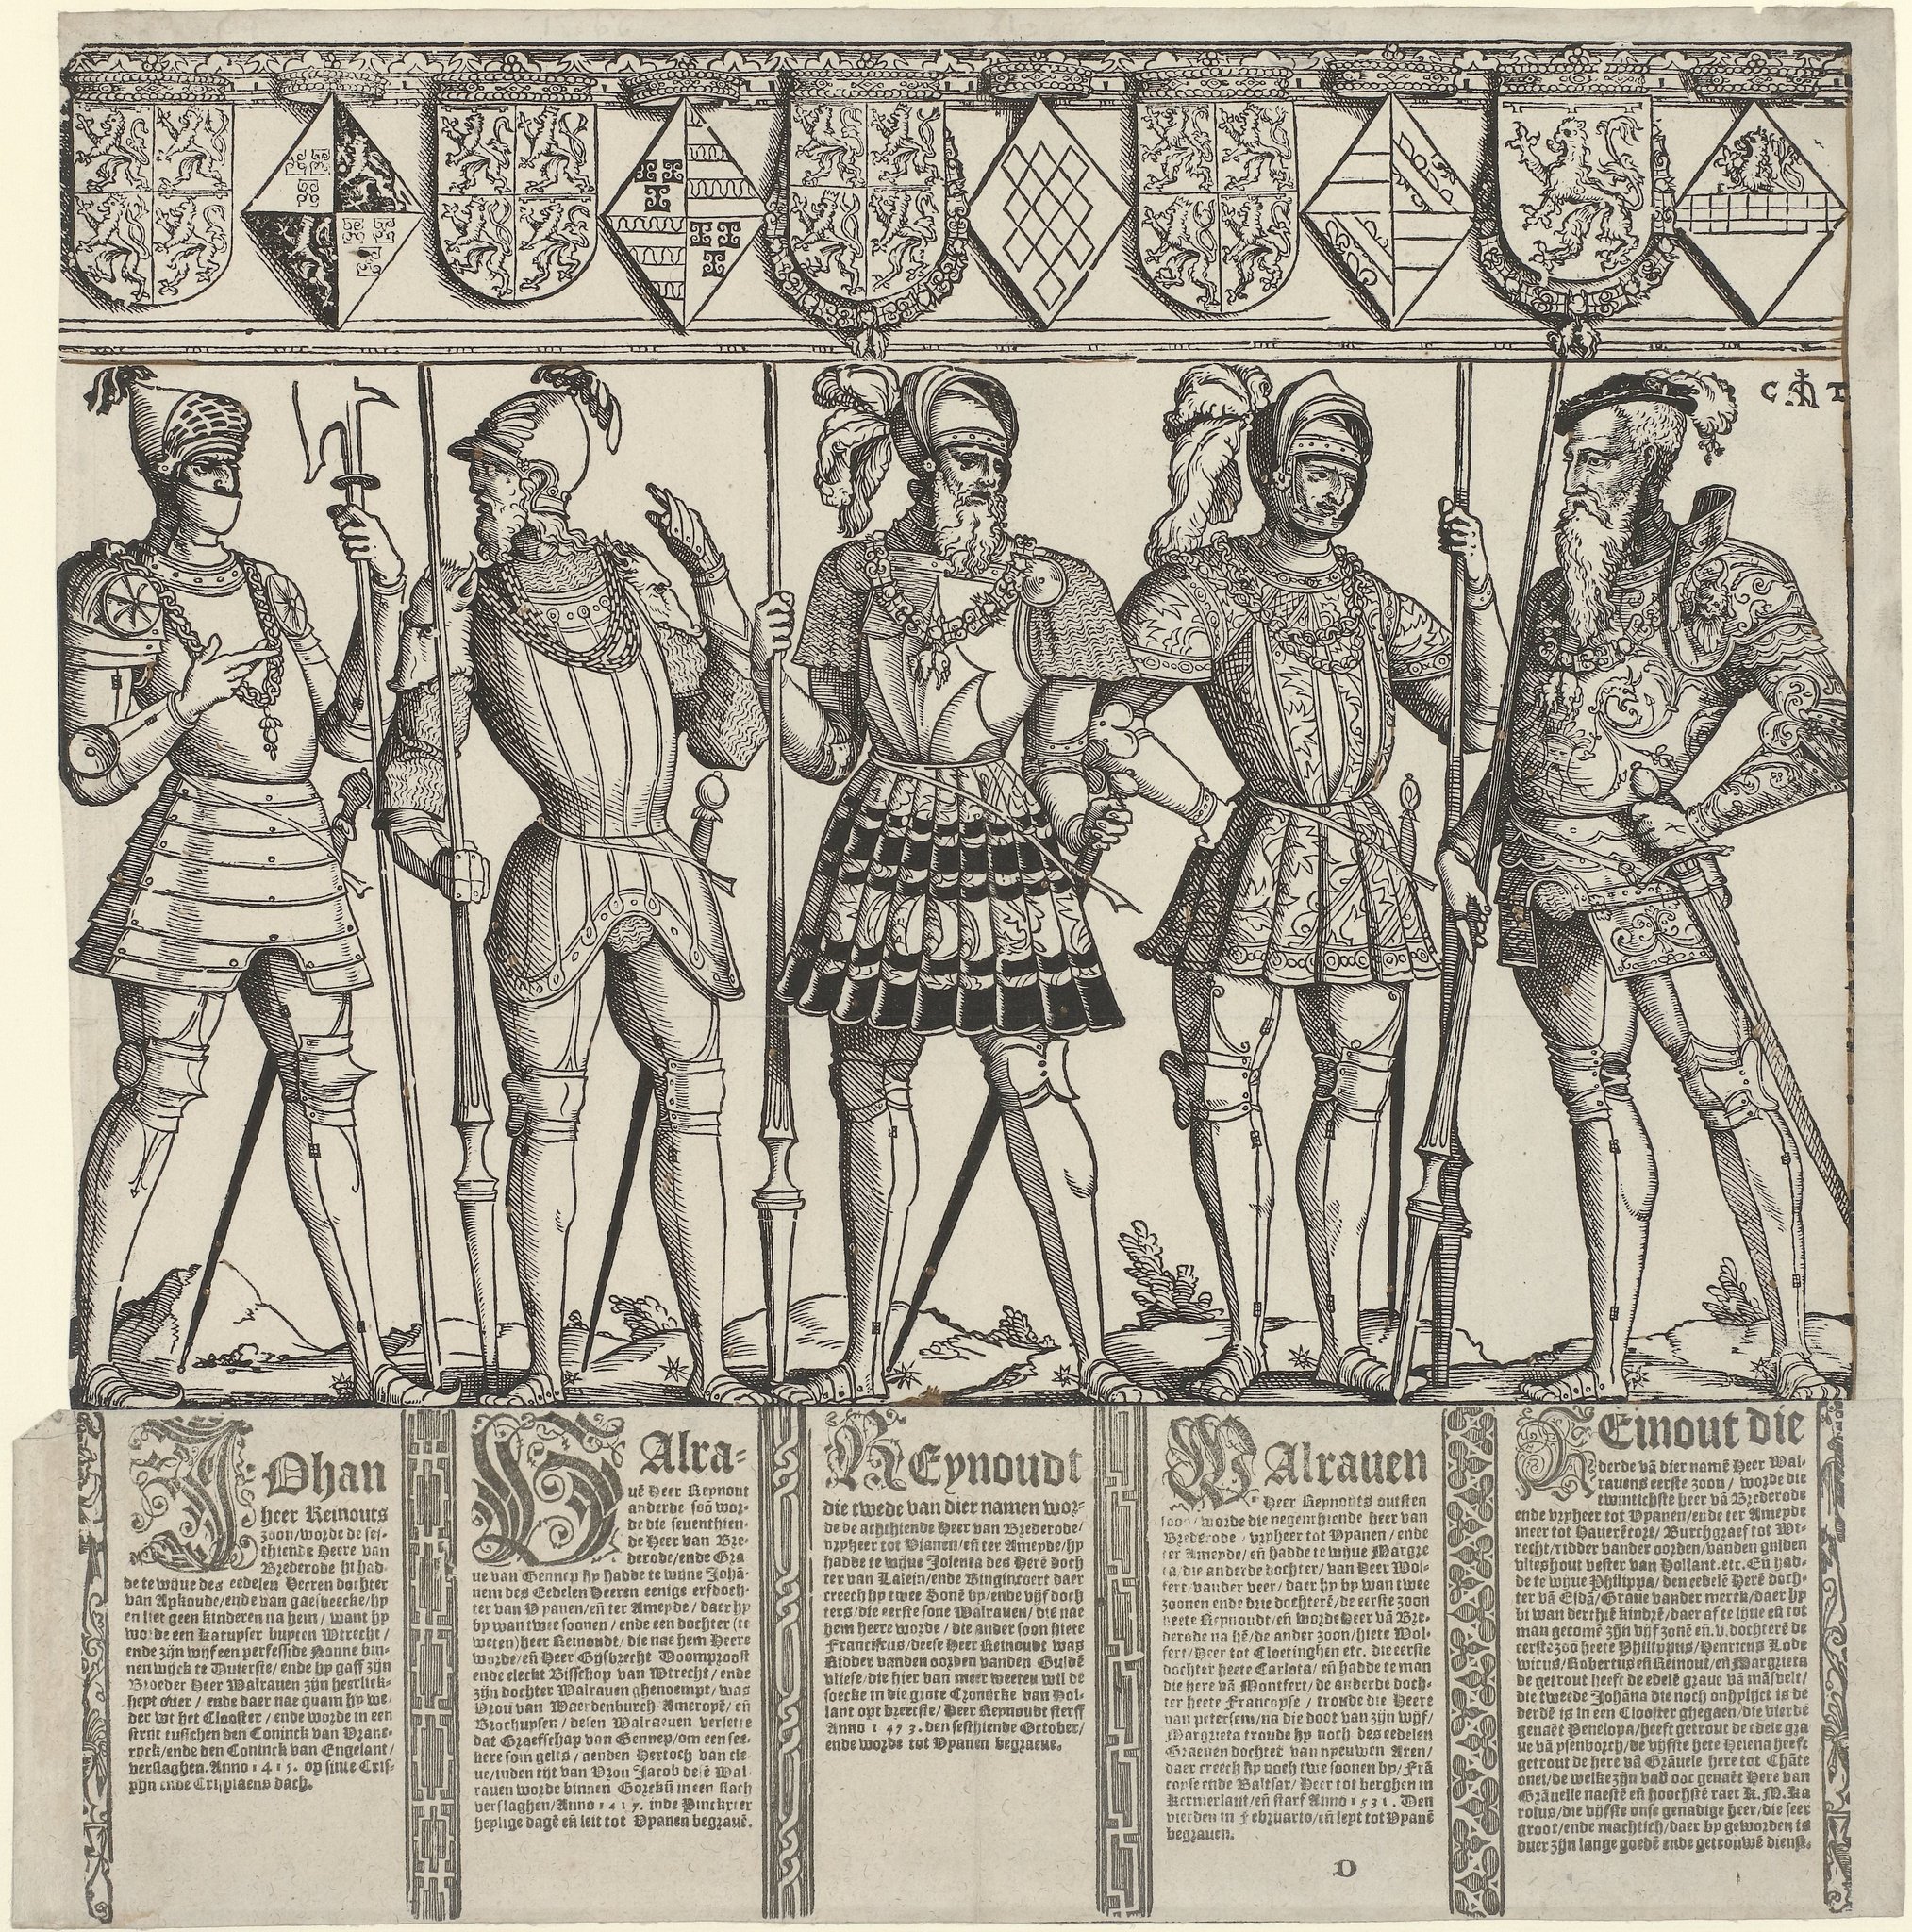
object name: print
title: Heren van Brederode, van Zyphridus tot en met Reinout III (rechter blad)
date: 1550-1551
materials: paper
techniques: letterpress printing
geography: amsterdam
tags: historical persons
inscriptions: collector's mark: Lugt 2228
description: Rechter blad van een fries op vier losse bladen met twintig Heren van Brederode, van Zyphridus tot en met Reinout III. Vijf portretten van verschillende Heren van Brederode in wapenrusting. In de bovenmarge hun wapens en de wapens van hun vrouwen. In de ondermarge hun namen en vijf kolommen met Nederlandse tekst in boekdruk over hun levens.